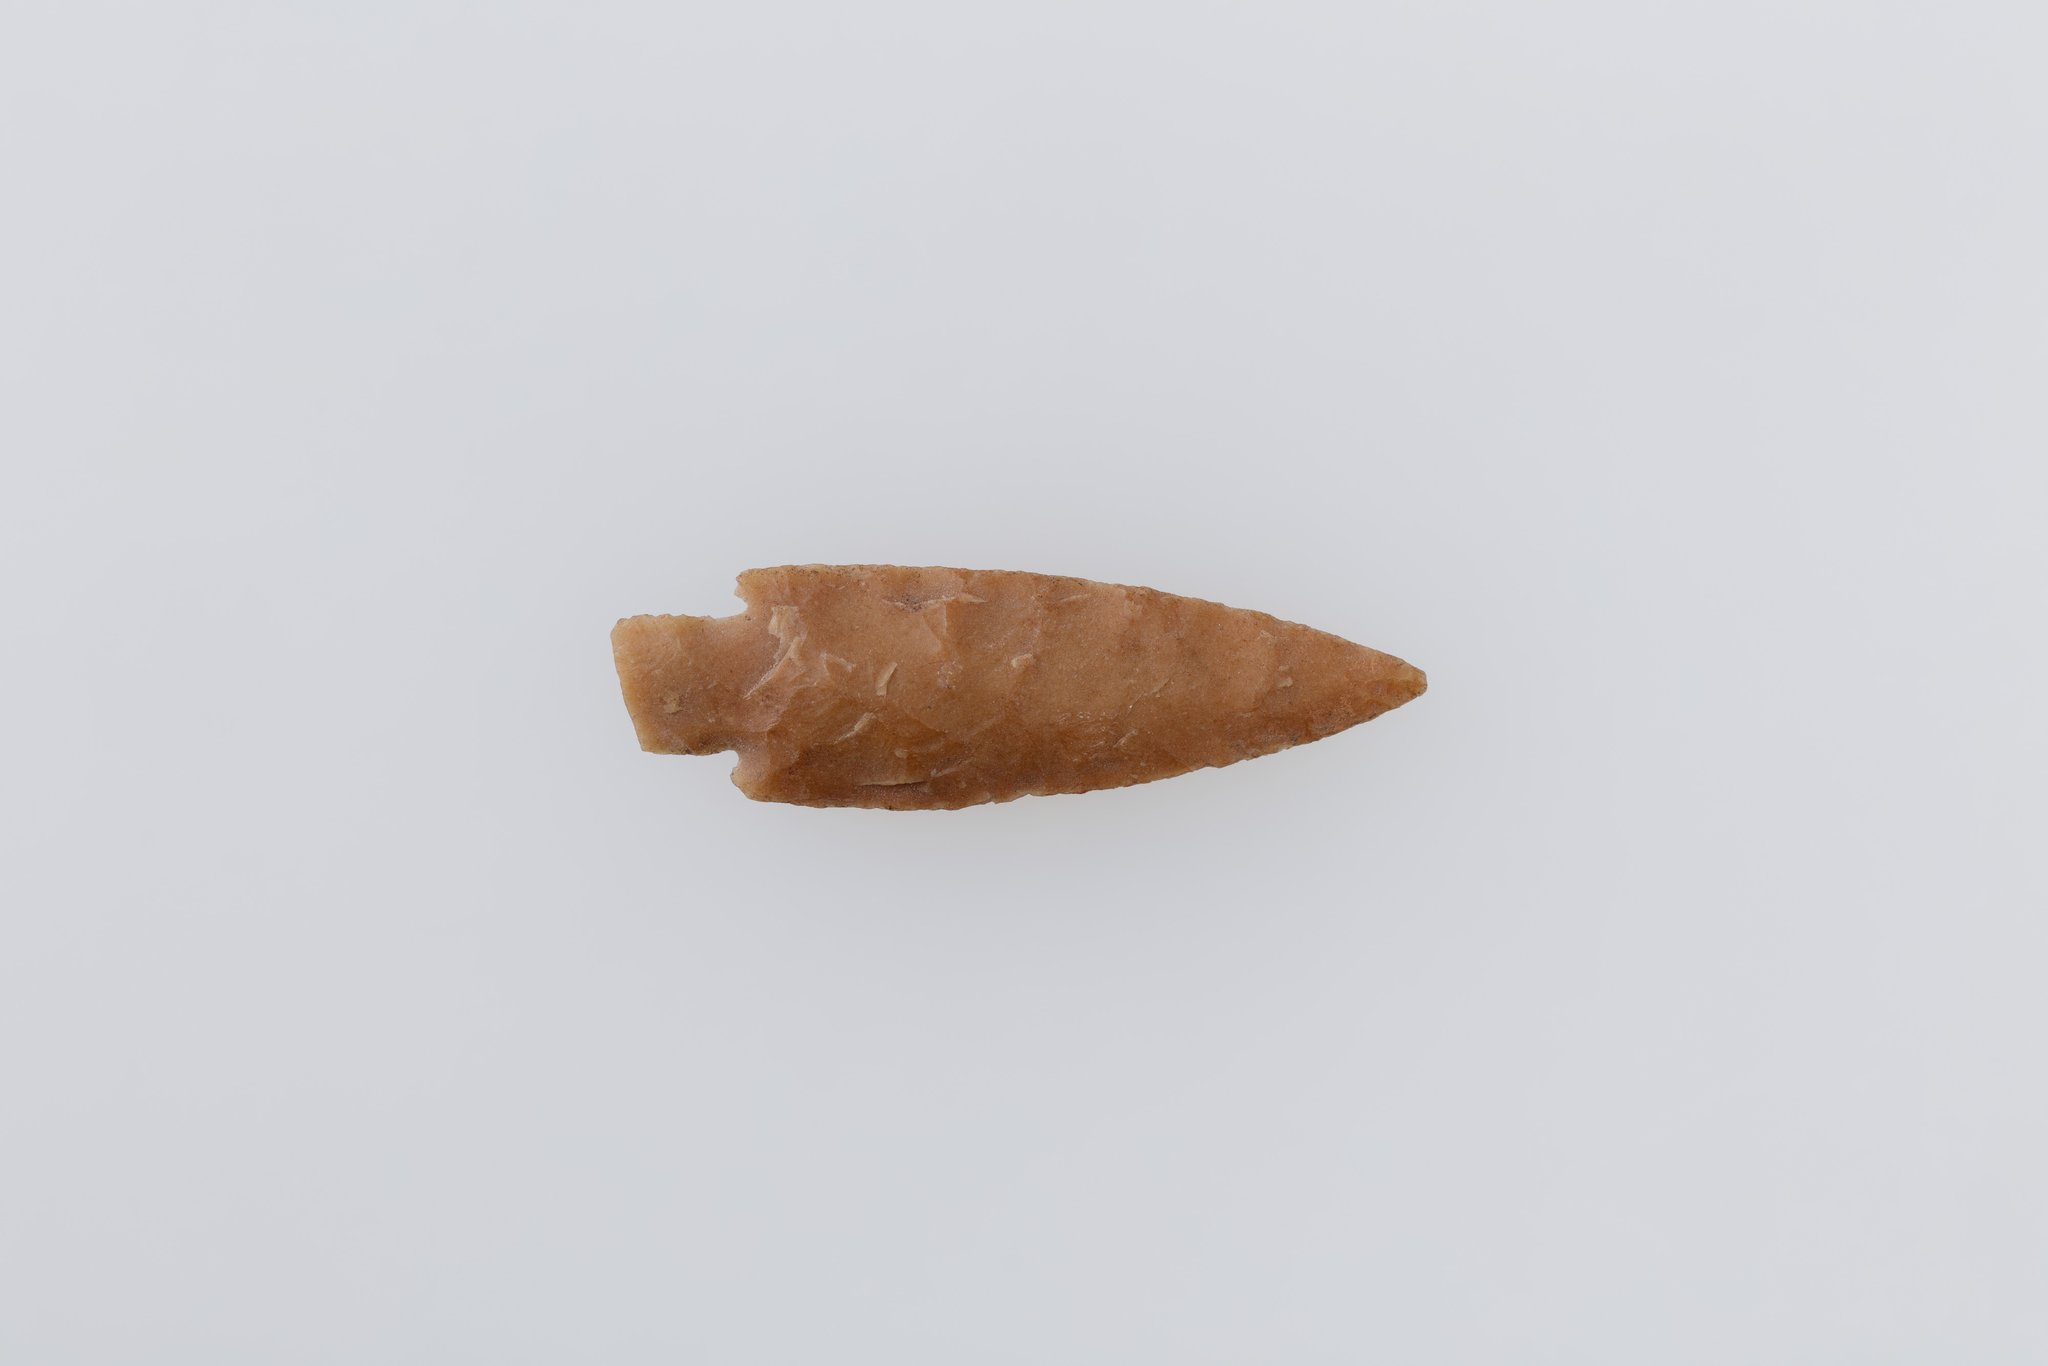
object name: arrowhead, projectile point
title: Projectile Point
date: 3100-2649 BCE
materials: stone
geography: egypt